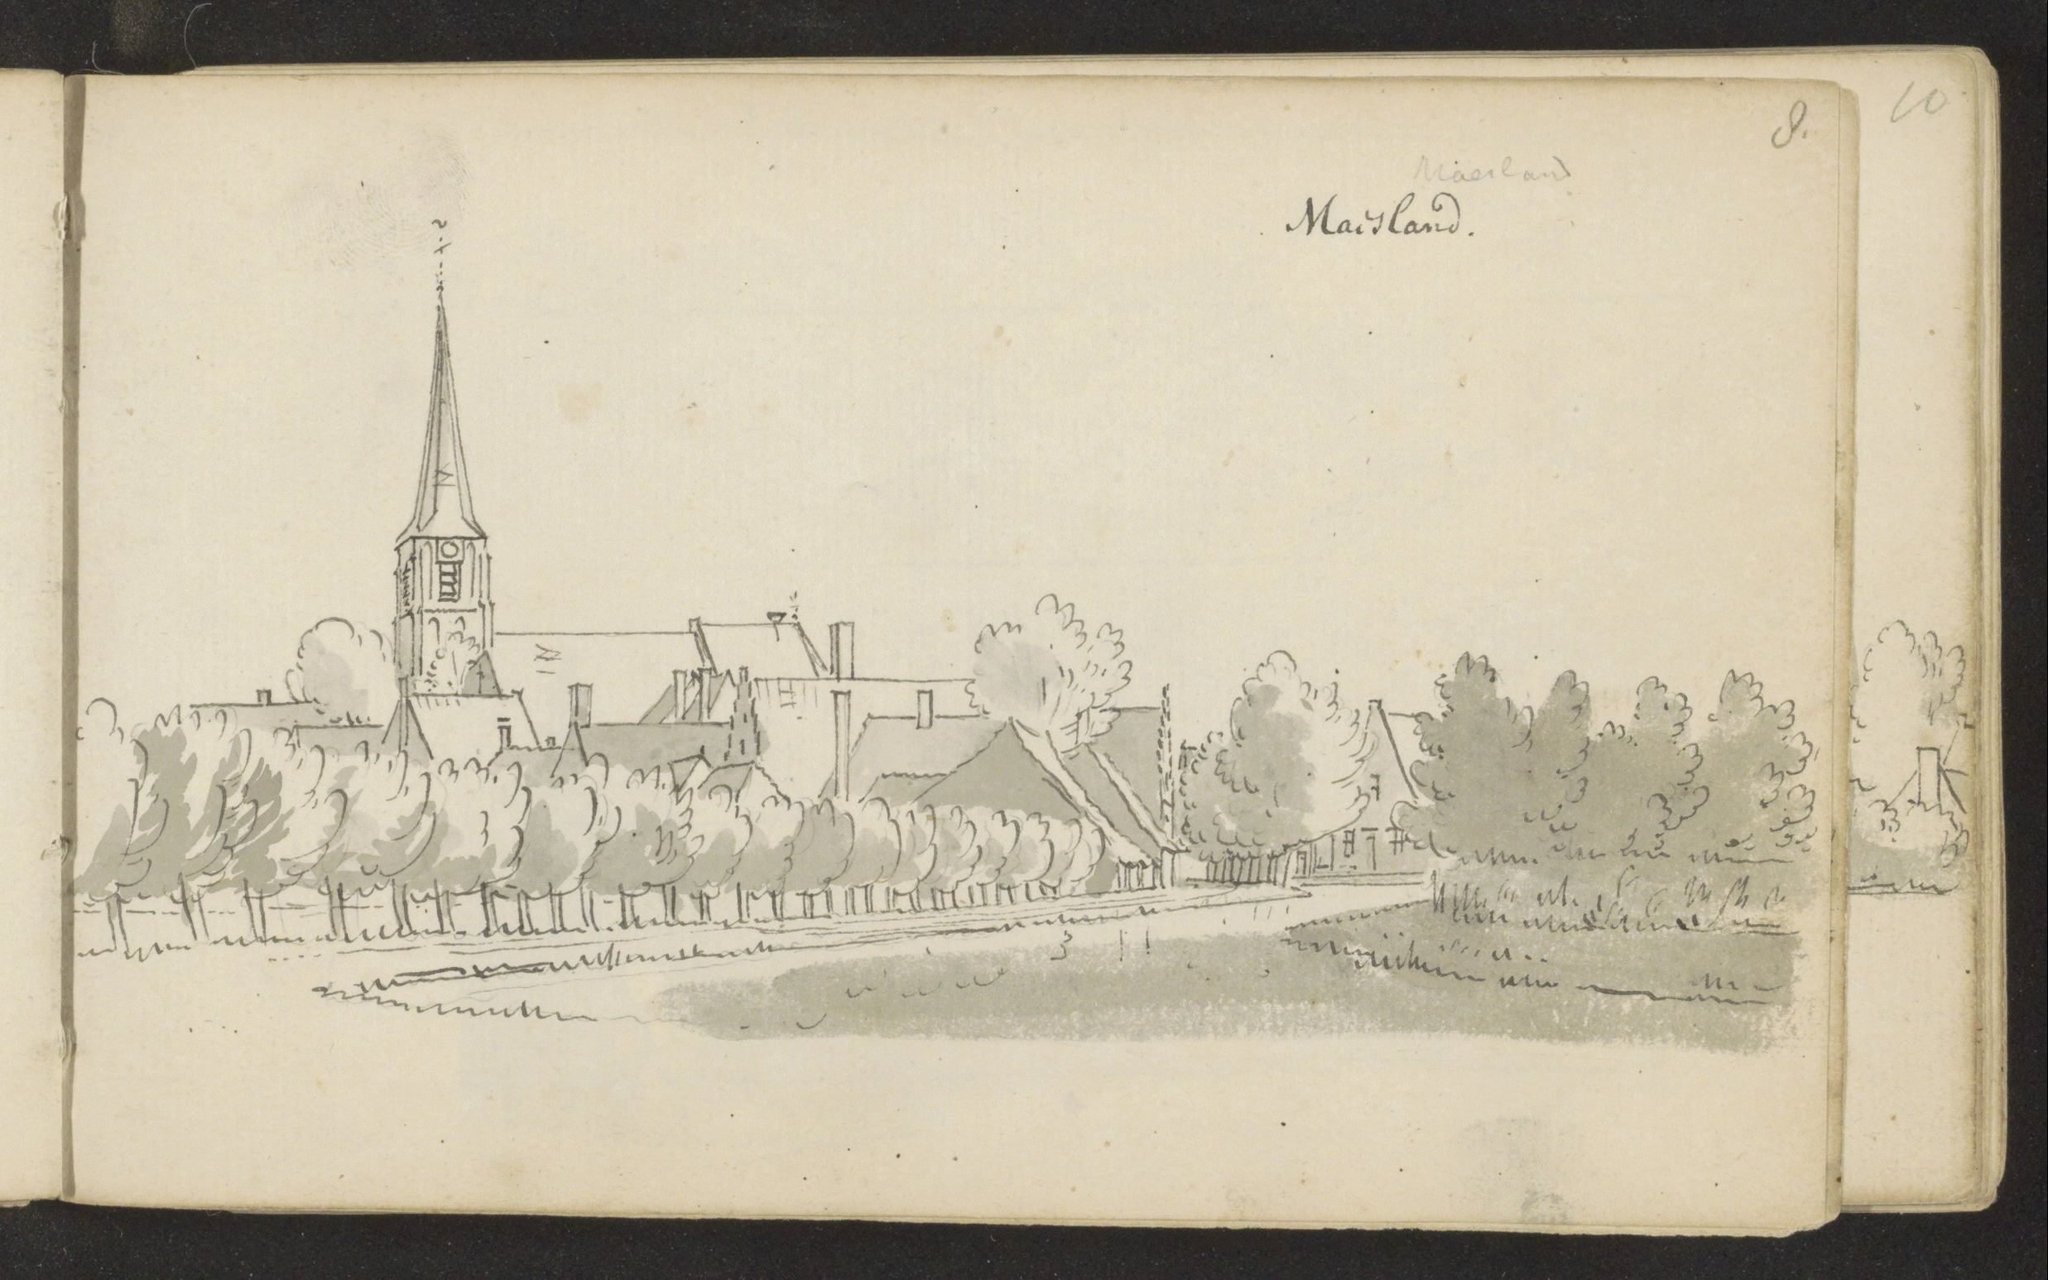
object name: sketchbook leaf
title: Dorpsgezicht te Maasland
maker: abraham de haen (ii)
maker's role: draughtsman, print maker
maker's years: 1707-1748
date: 1731-1732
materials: ink, paper, pencil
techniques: brush, pen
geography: maasland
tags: prospect of village, silhouette of village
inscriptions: annotation: ‘Maesland’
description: Blad 8 recto uit een schetsboek met 78 bladen.